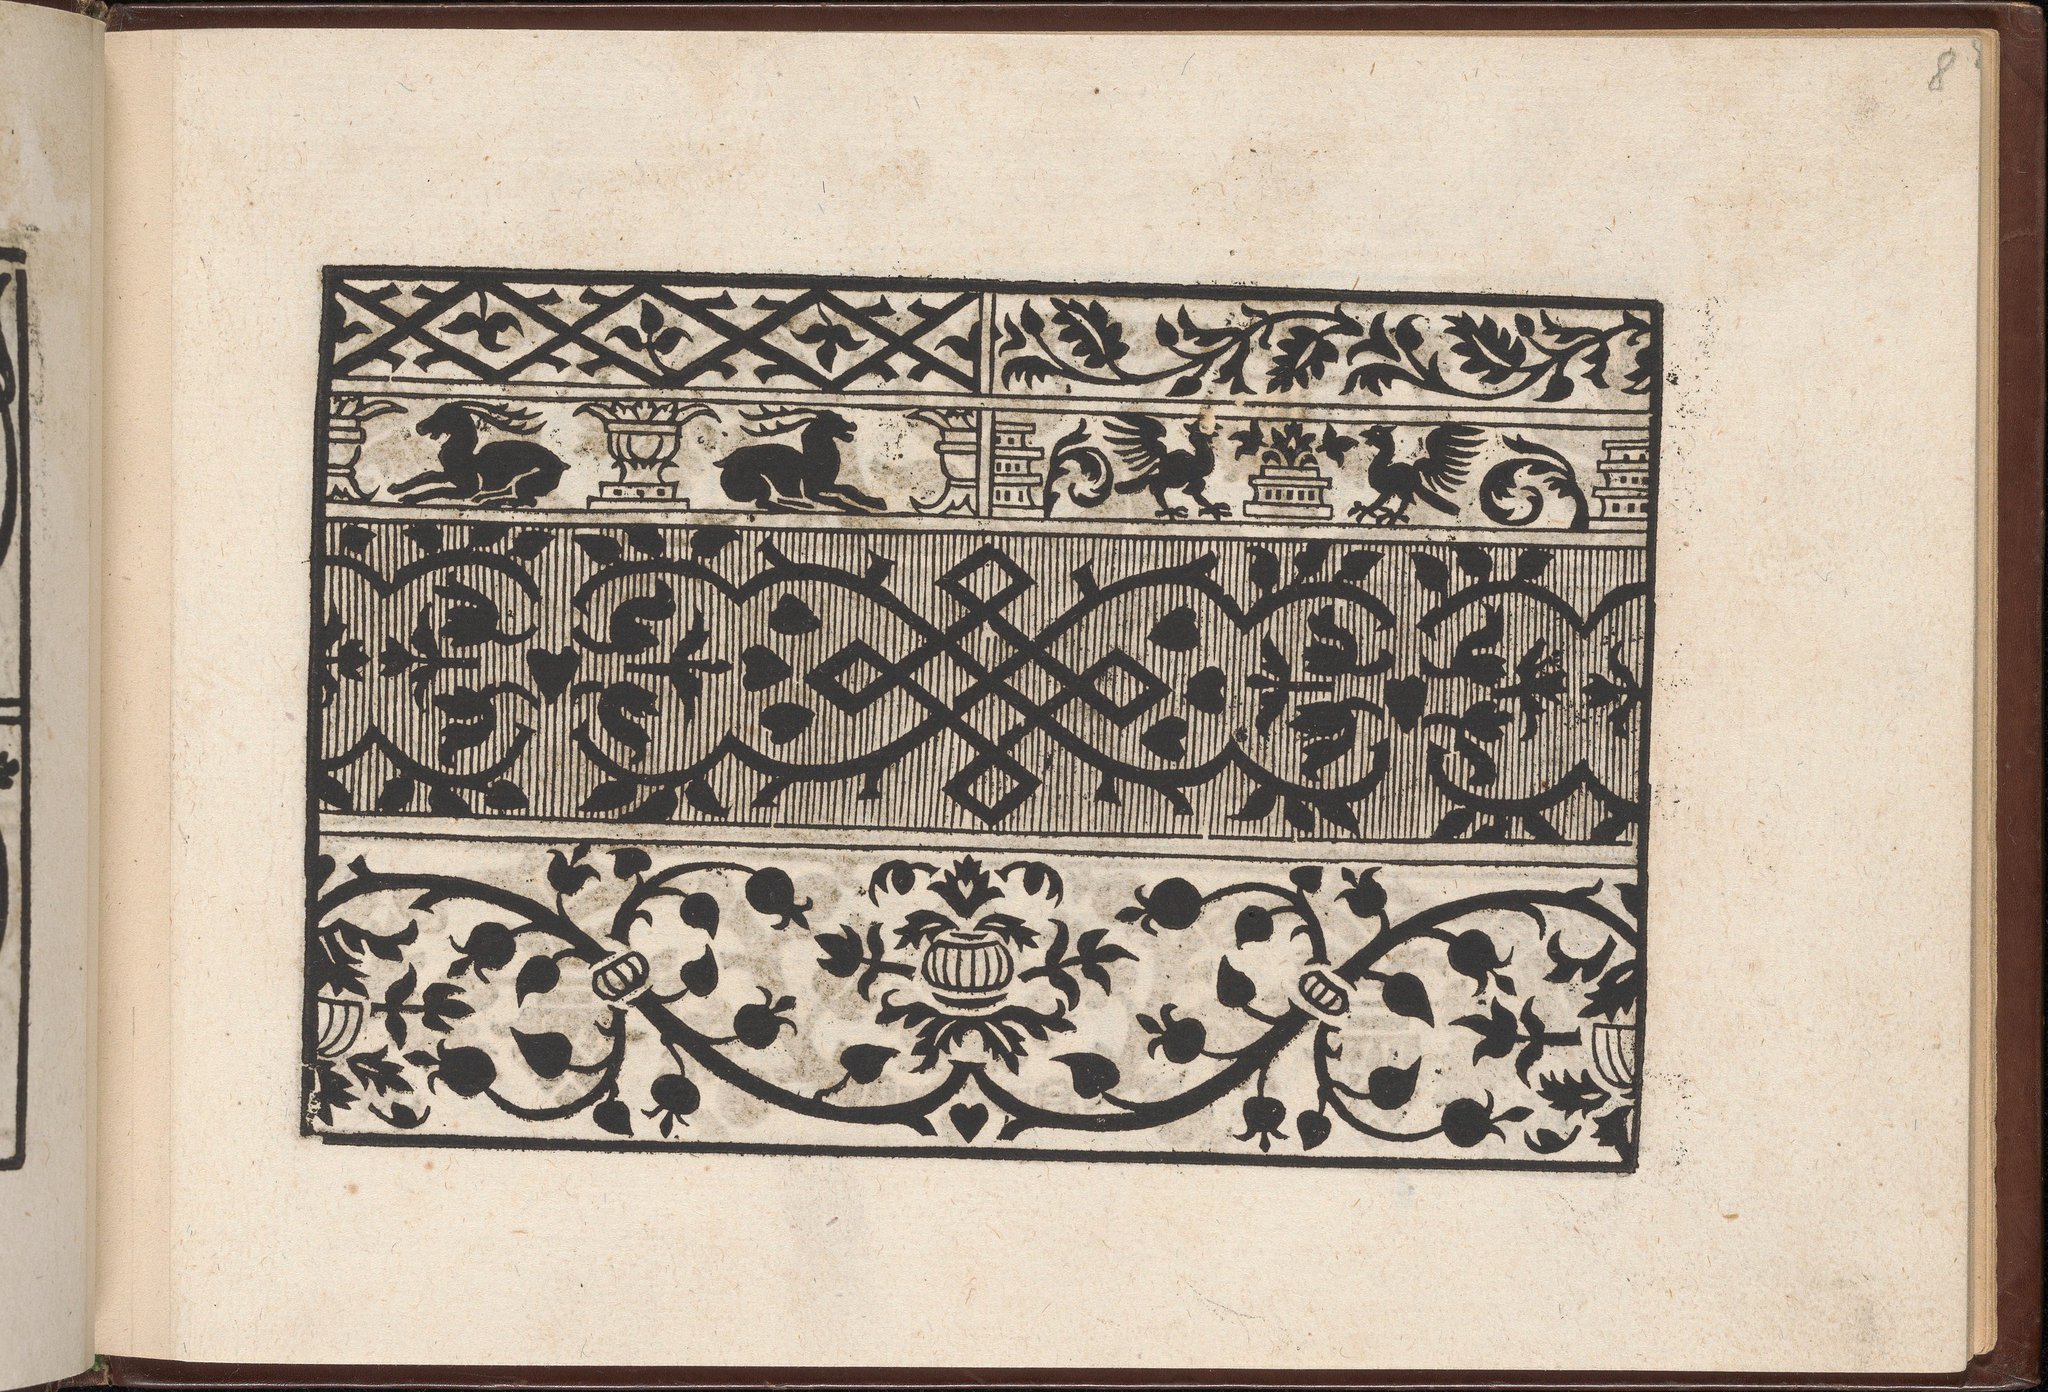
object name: book print ornament architecture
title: Page from Eyn Newe kunstlich moetdelboech alle kunst (Page 8r)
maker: peter quentel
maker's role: publisher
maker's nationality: german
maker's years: 1500-1550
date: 1532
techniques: woodcut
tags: animals,griffins